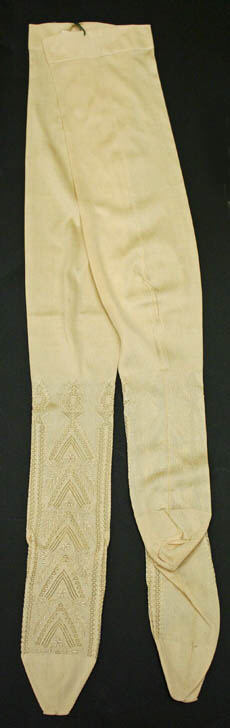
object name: stocking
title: Stockings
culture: french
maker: bon marché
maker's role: department store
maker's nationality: french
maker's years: 1852-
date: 1867-1900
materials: silk